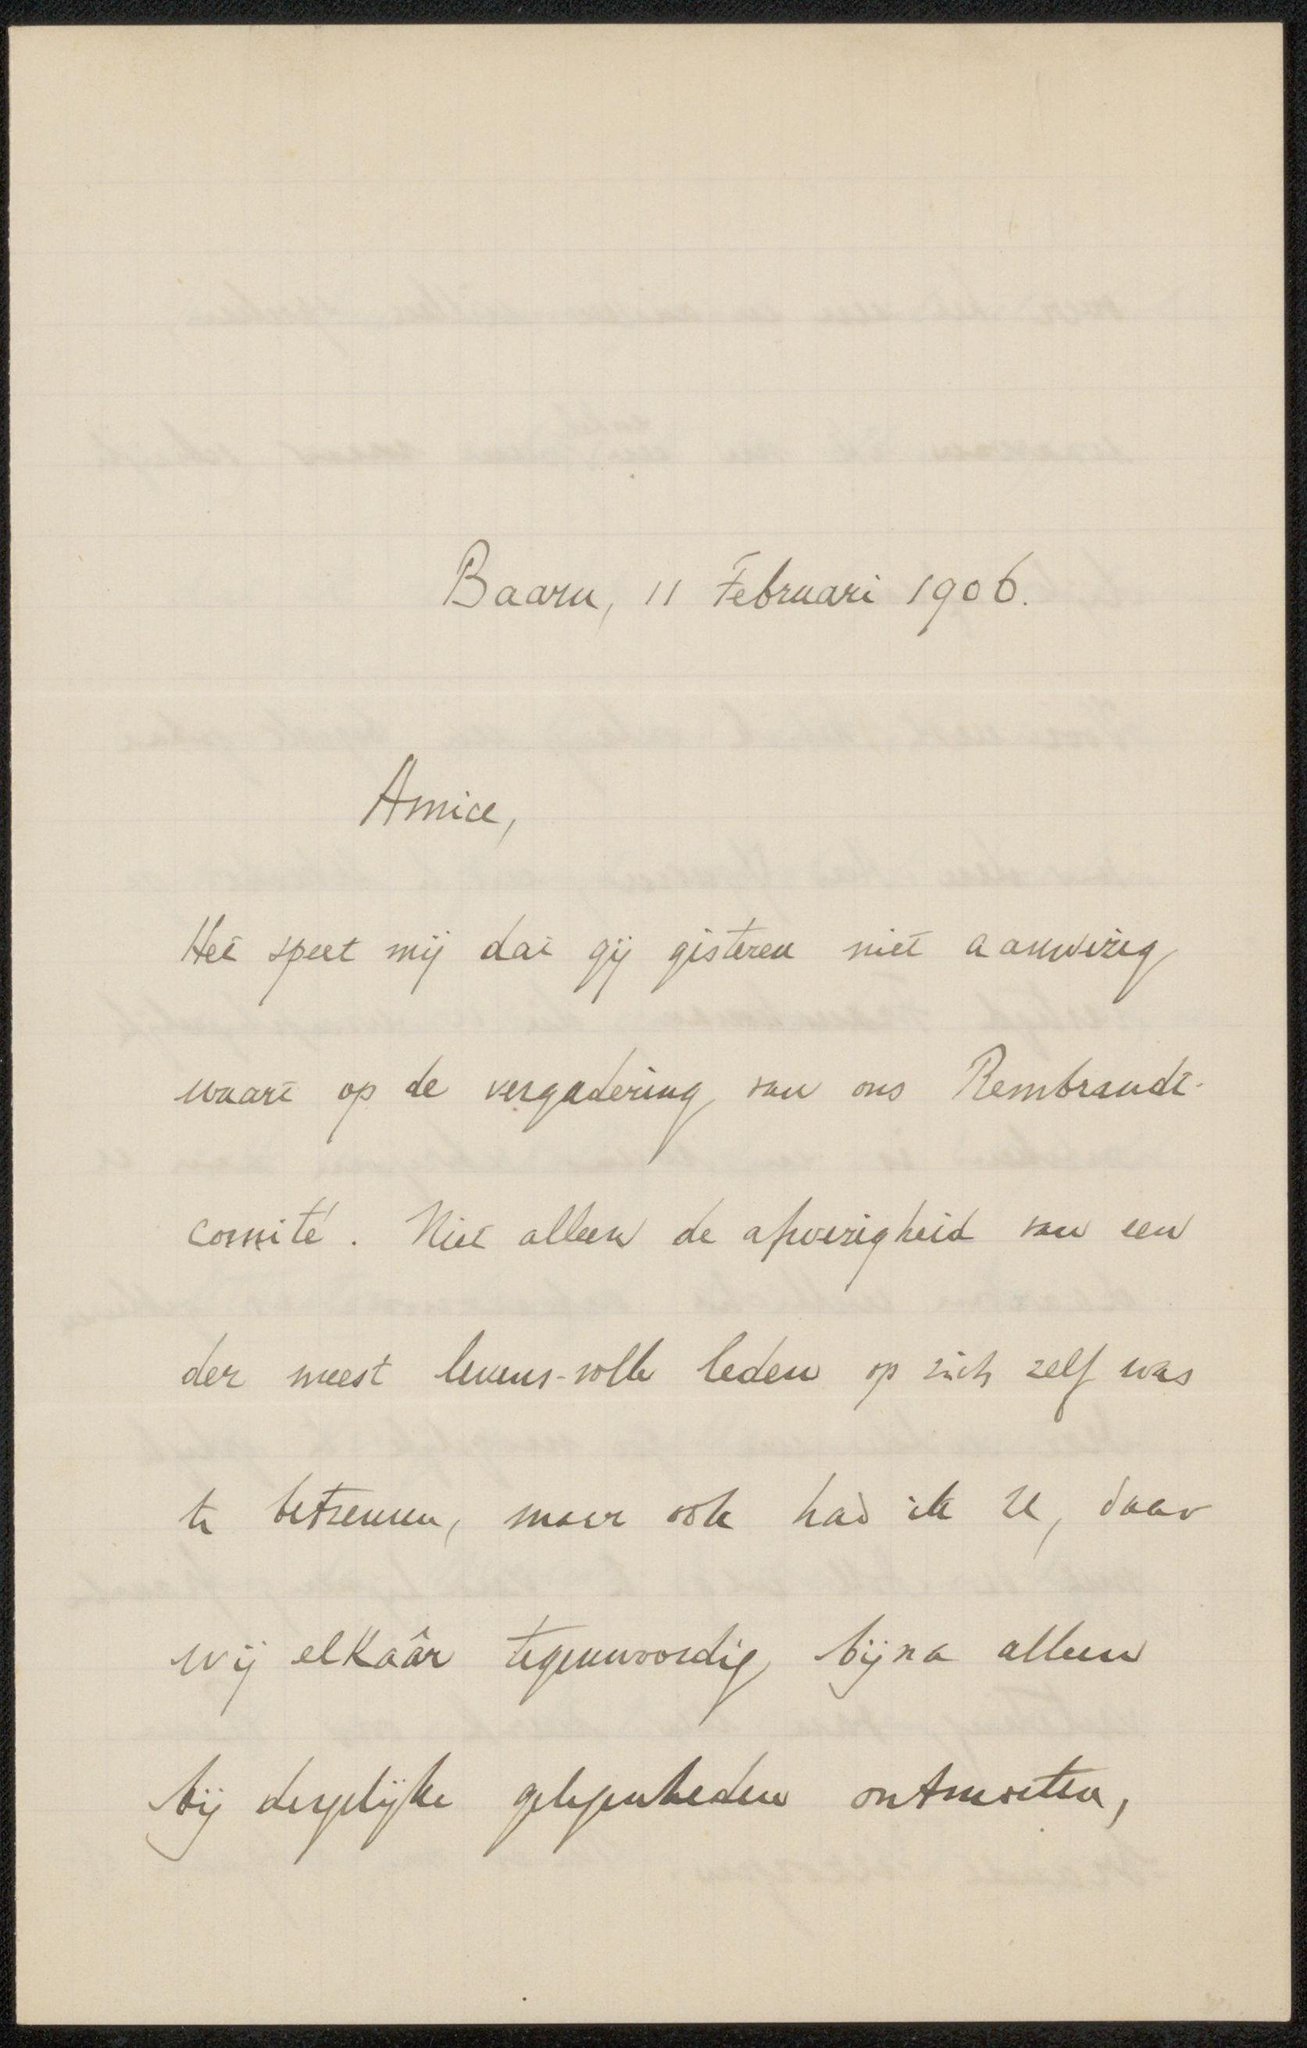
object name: letter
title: Brief aan Jan Veth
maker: karel johan lodewijk alberdingk thijm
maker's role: criticus, prozaschrijver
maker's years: 1864-1952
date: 1906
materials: ink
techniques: pen, writing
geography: baarn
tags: jan veth, amsterdam, painter, print maker, draughtsman, rembrandt van rijn, paris, stéphane mallarmé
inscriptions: collector's mark: ‘RPK’